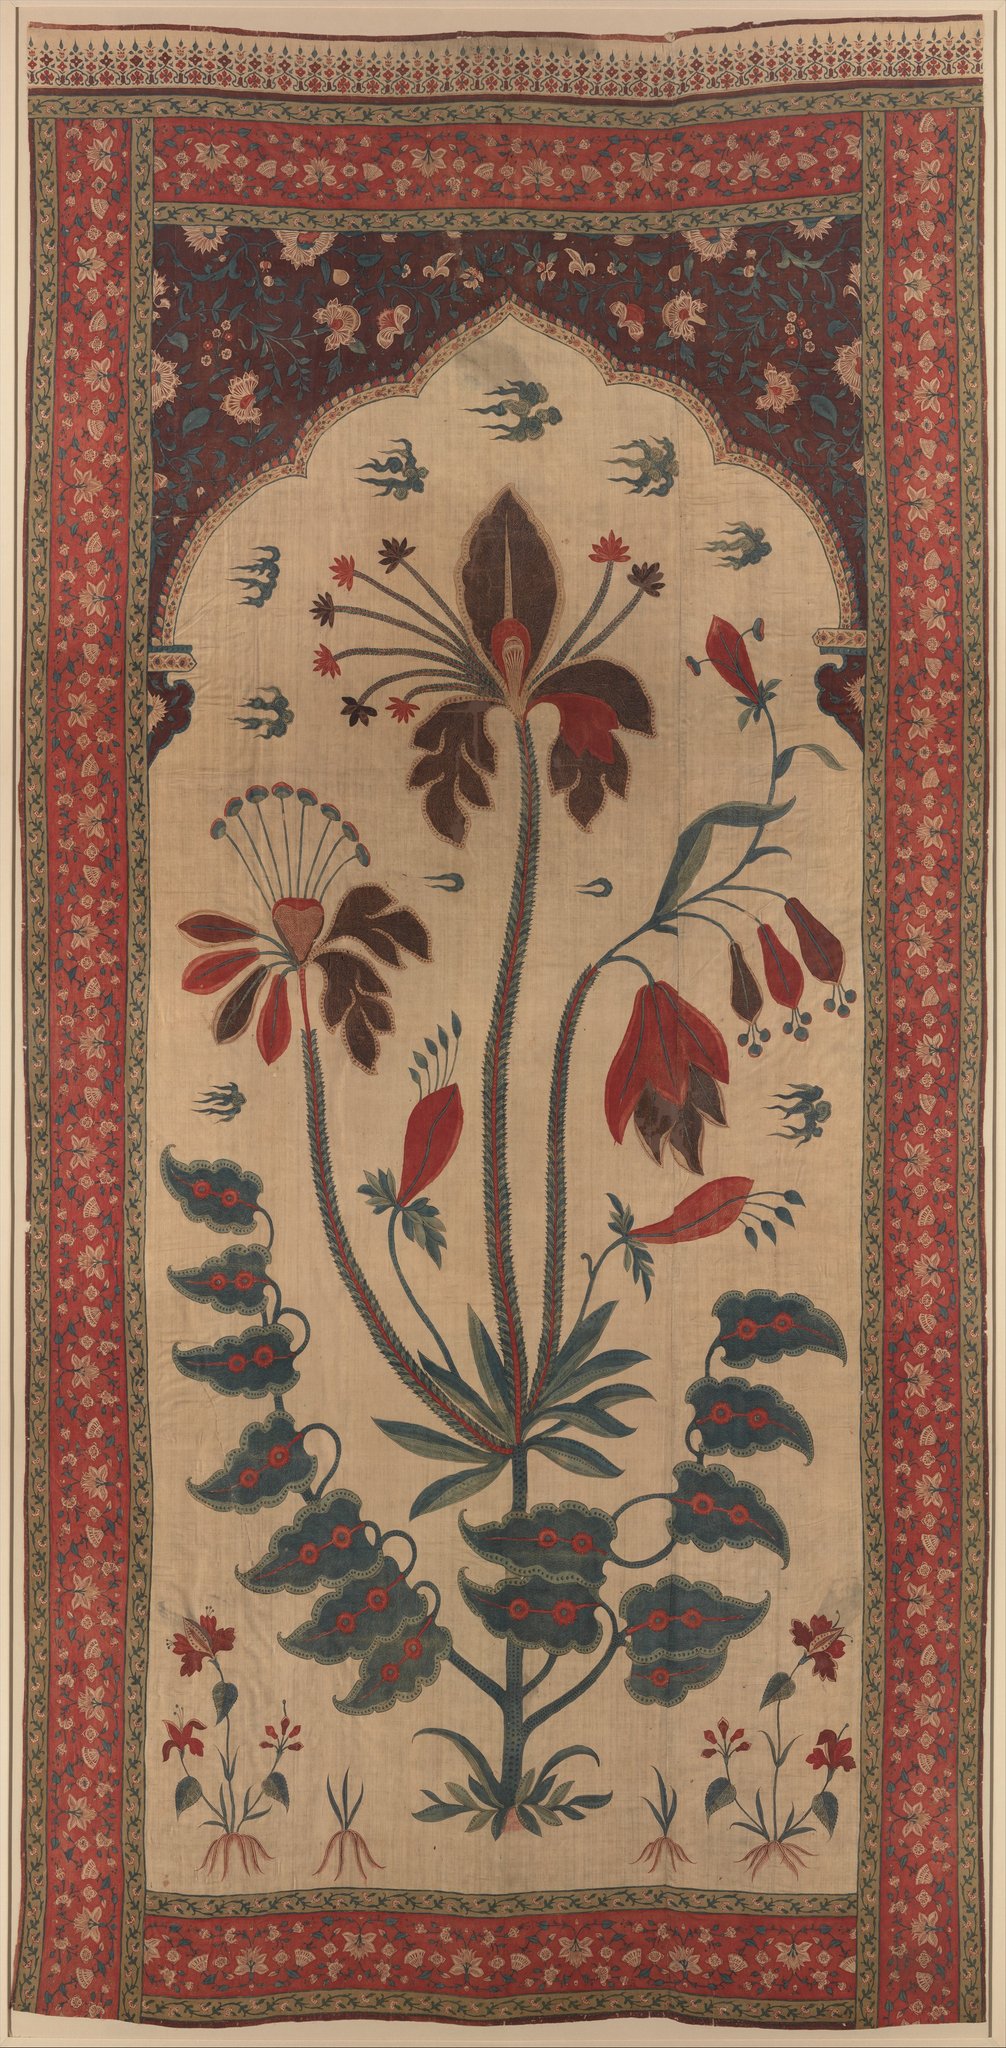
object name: panel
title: Panel from a Tent Lining (Qanat)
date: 1601-1700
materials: cotton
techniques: dyeing, painting, weave, resist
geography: india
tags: flowers,plants,leaves